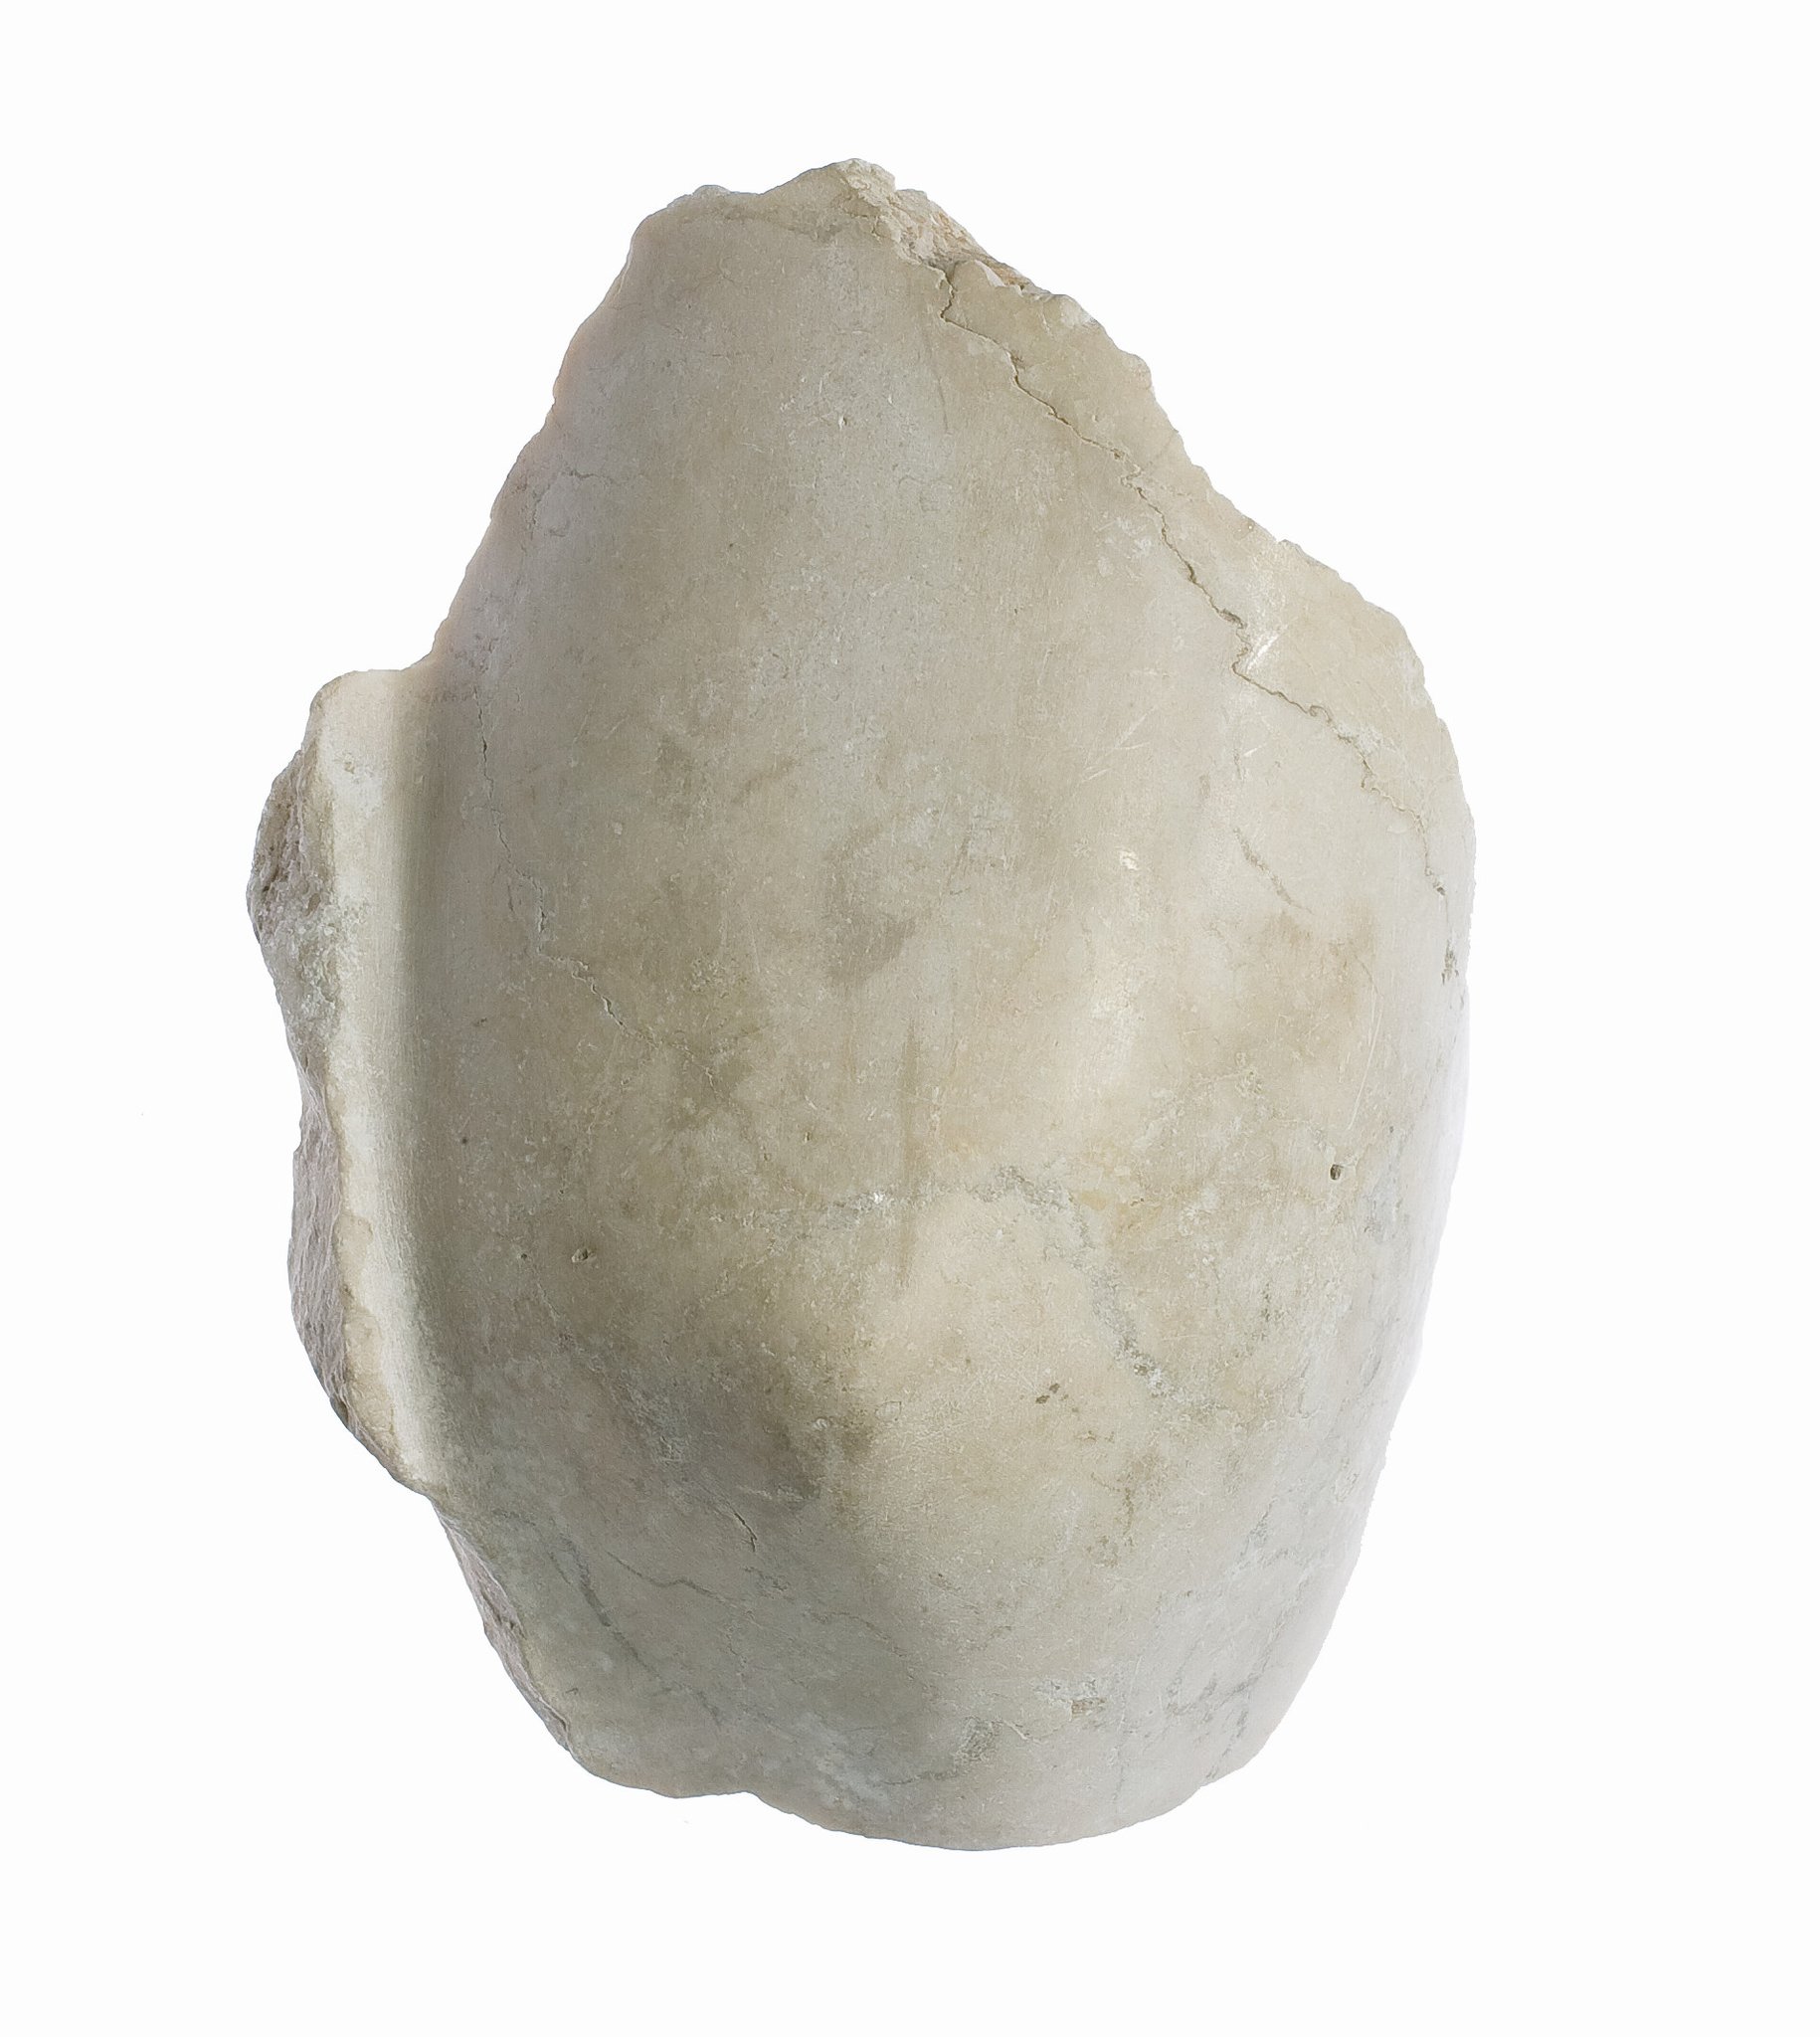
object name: elbow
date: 1353-1336 BCE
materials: limestone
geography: egypt